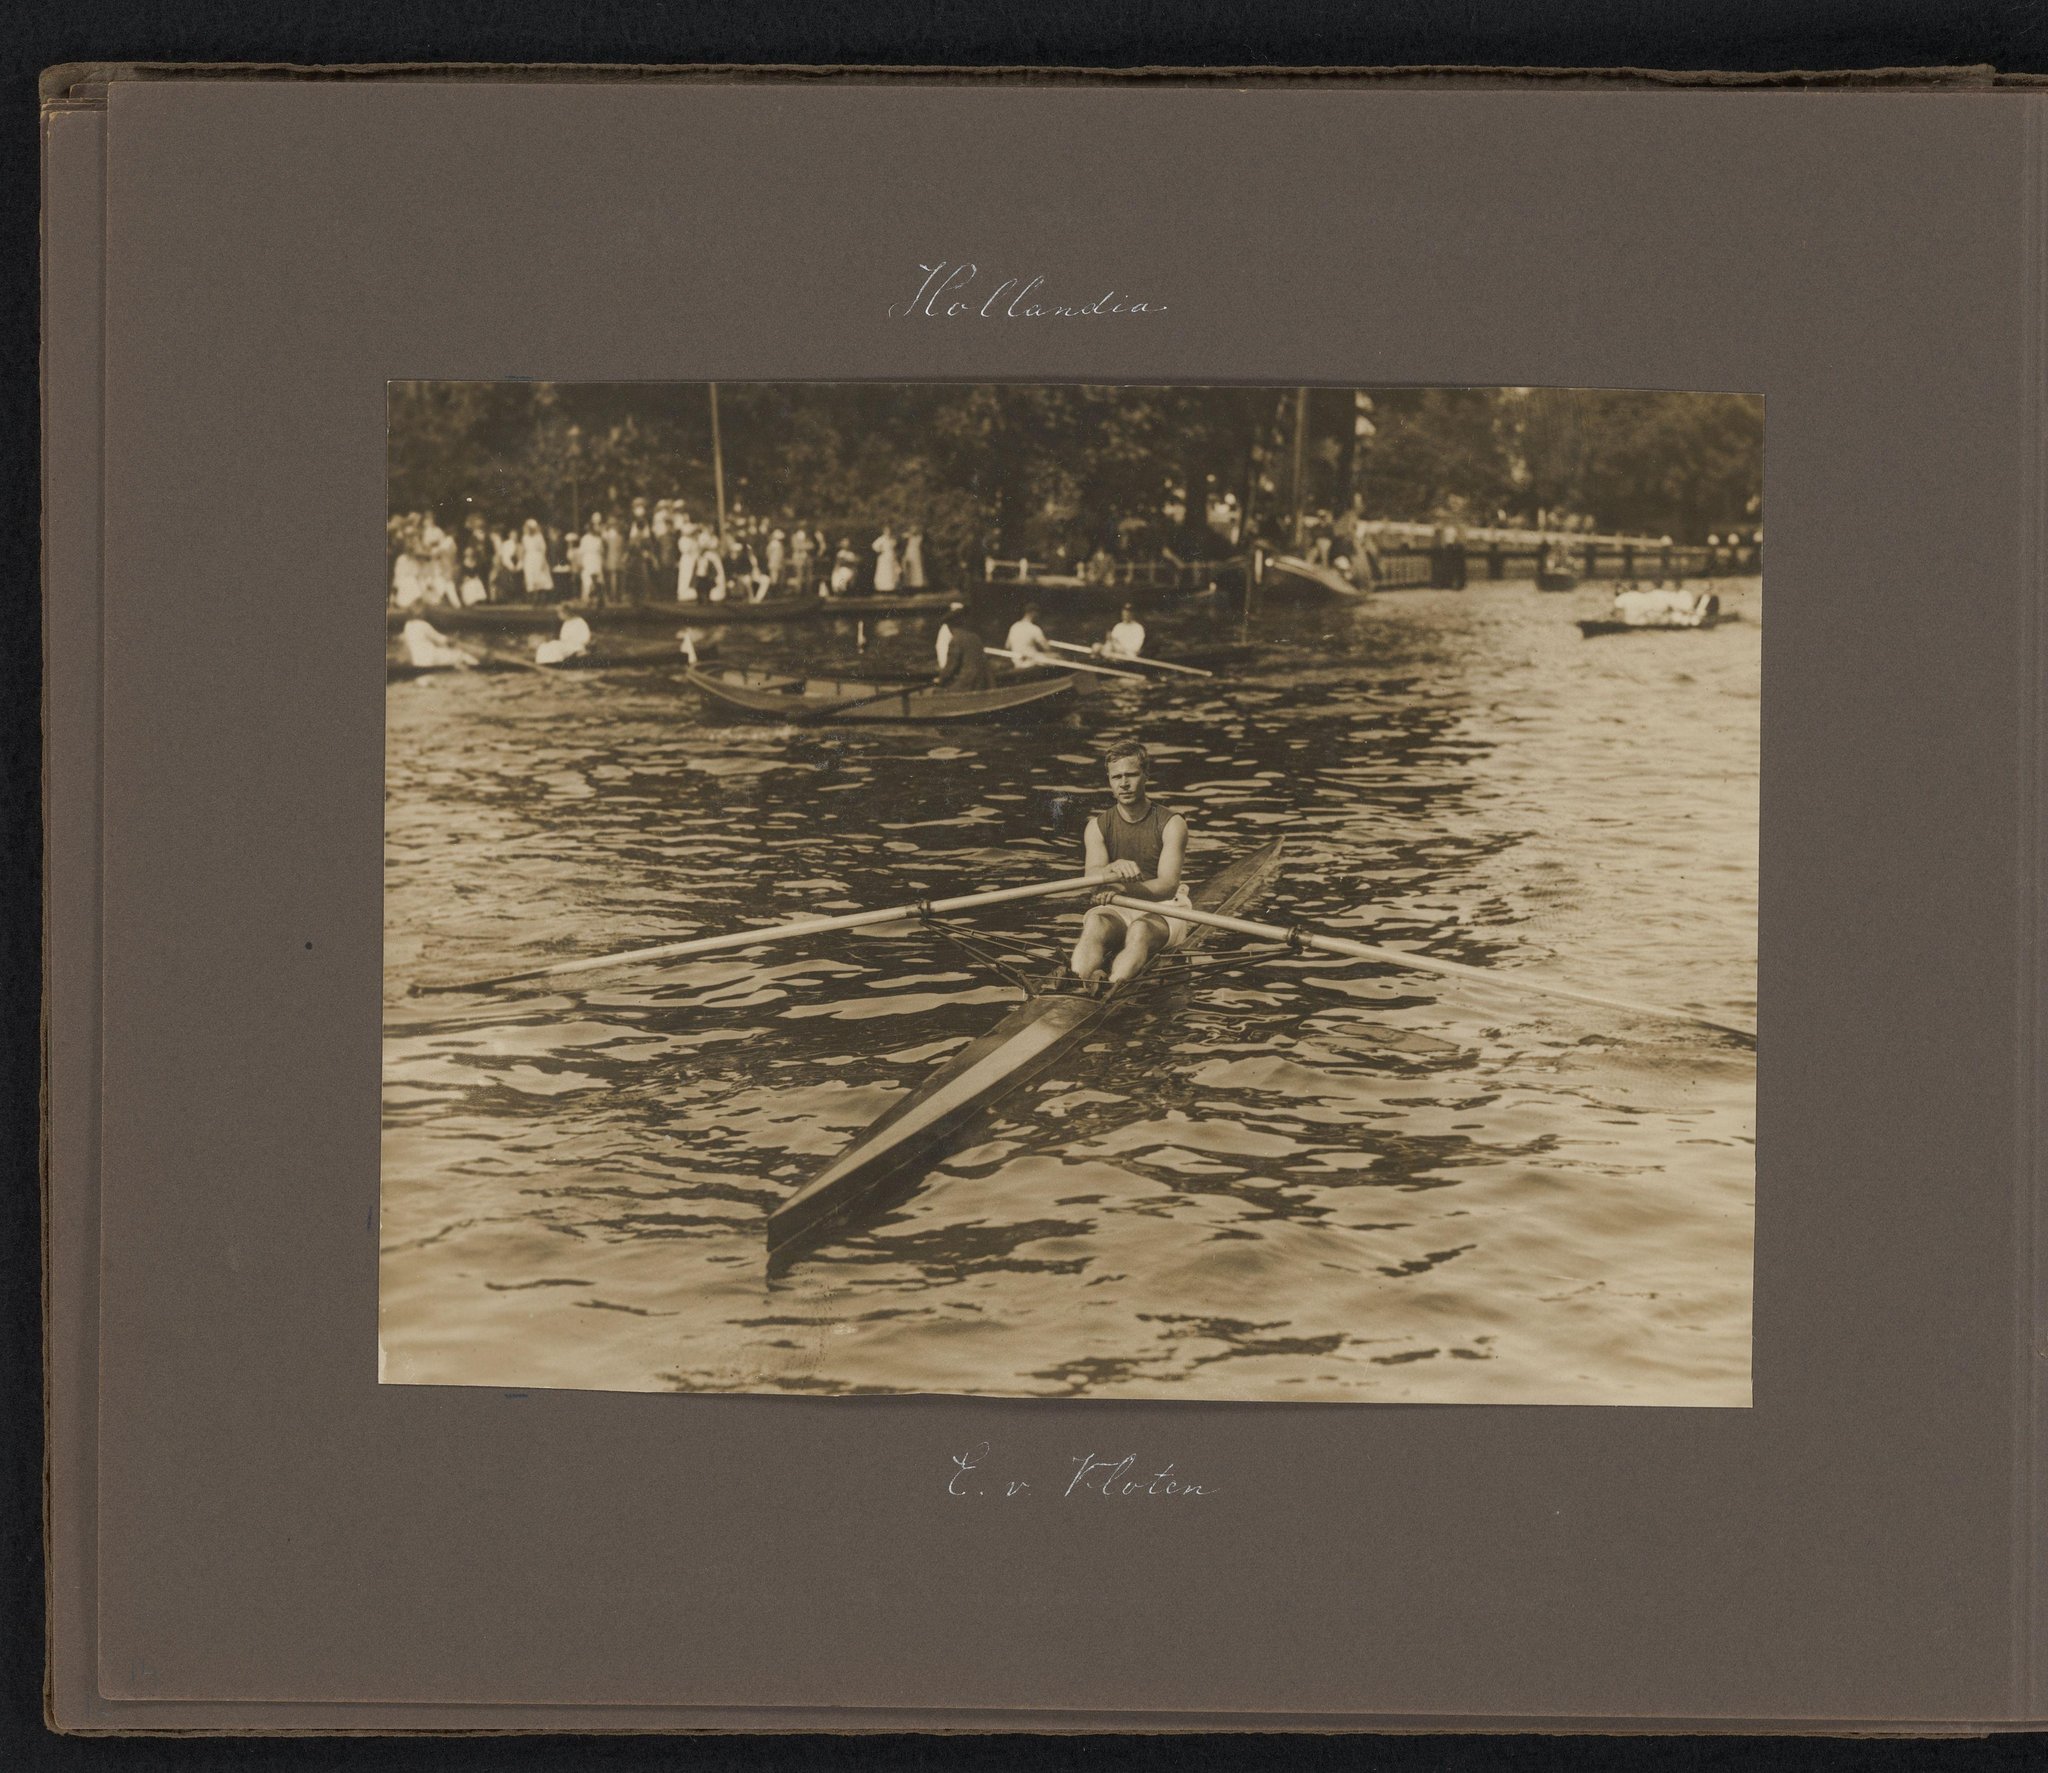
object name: album leaf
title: E. van Kloten in een eenmansboot tijdens de Hollandia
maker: Anonymous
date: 1915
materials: paper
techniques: gelatin silver print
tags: rowing facing backward, pulling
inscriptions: caption: ‘E. v Kloten’